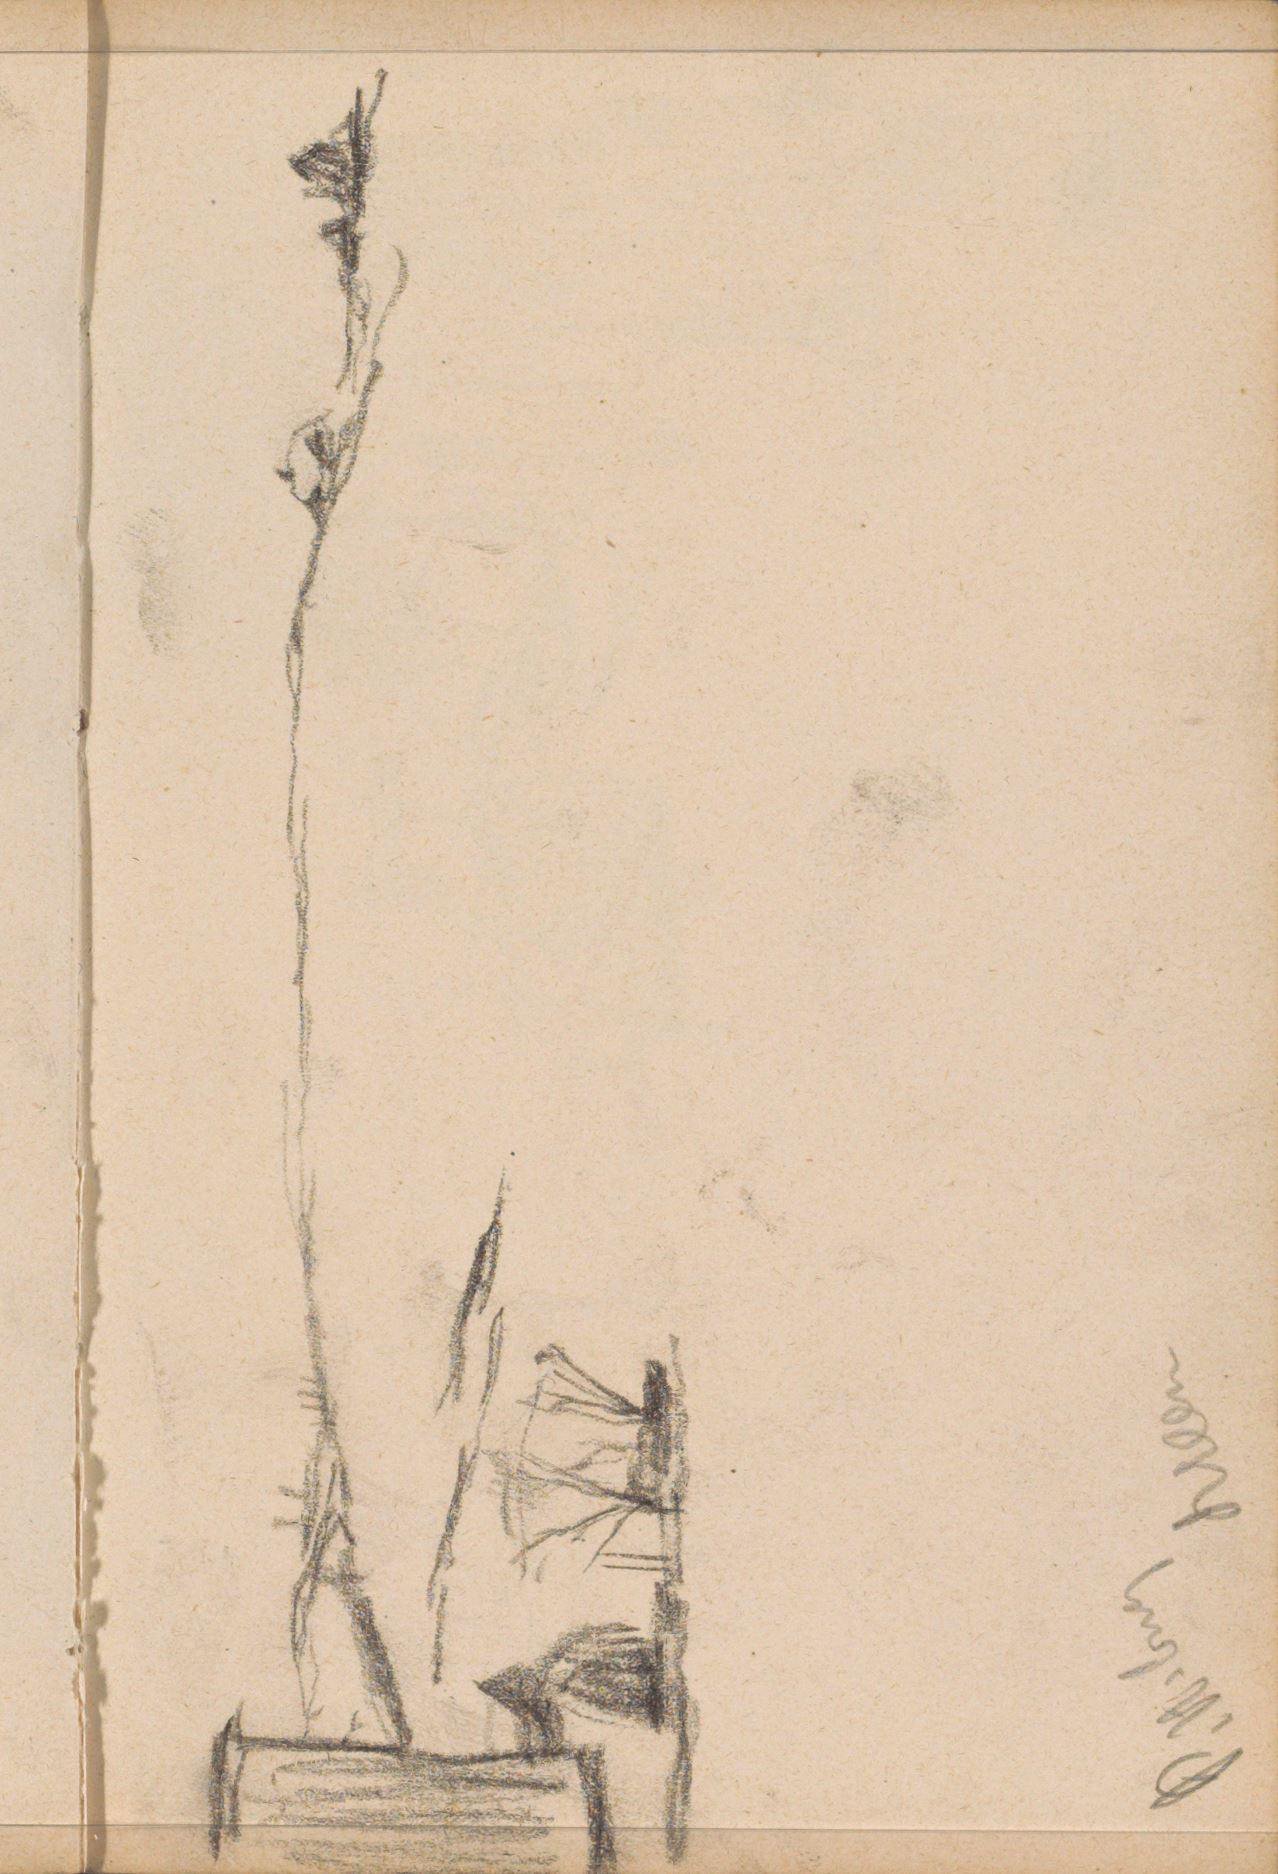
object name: sketchbook leaf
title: Heuvelachtig landschap in Pittsburgh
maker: george hendrik breitner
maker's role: draughtsman, painter, print maker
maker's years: 1857-1923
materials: chalk, paper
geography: pittsburgh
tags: low hill country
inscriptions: annotation: ‘Pittsburg/ [...]een’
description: Heuvelachtig landschap in Pittsburgh. Links een gebouw. Pagina 38 uit een schetsboek met 45 bladen vervaardigd in Amsterdam en Pittsburgh.